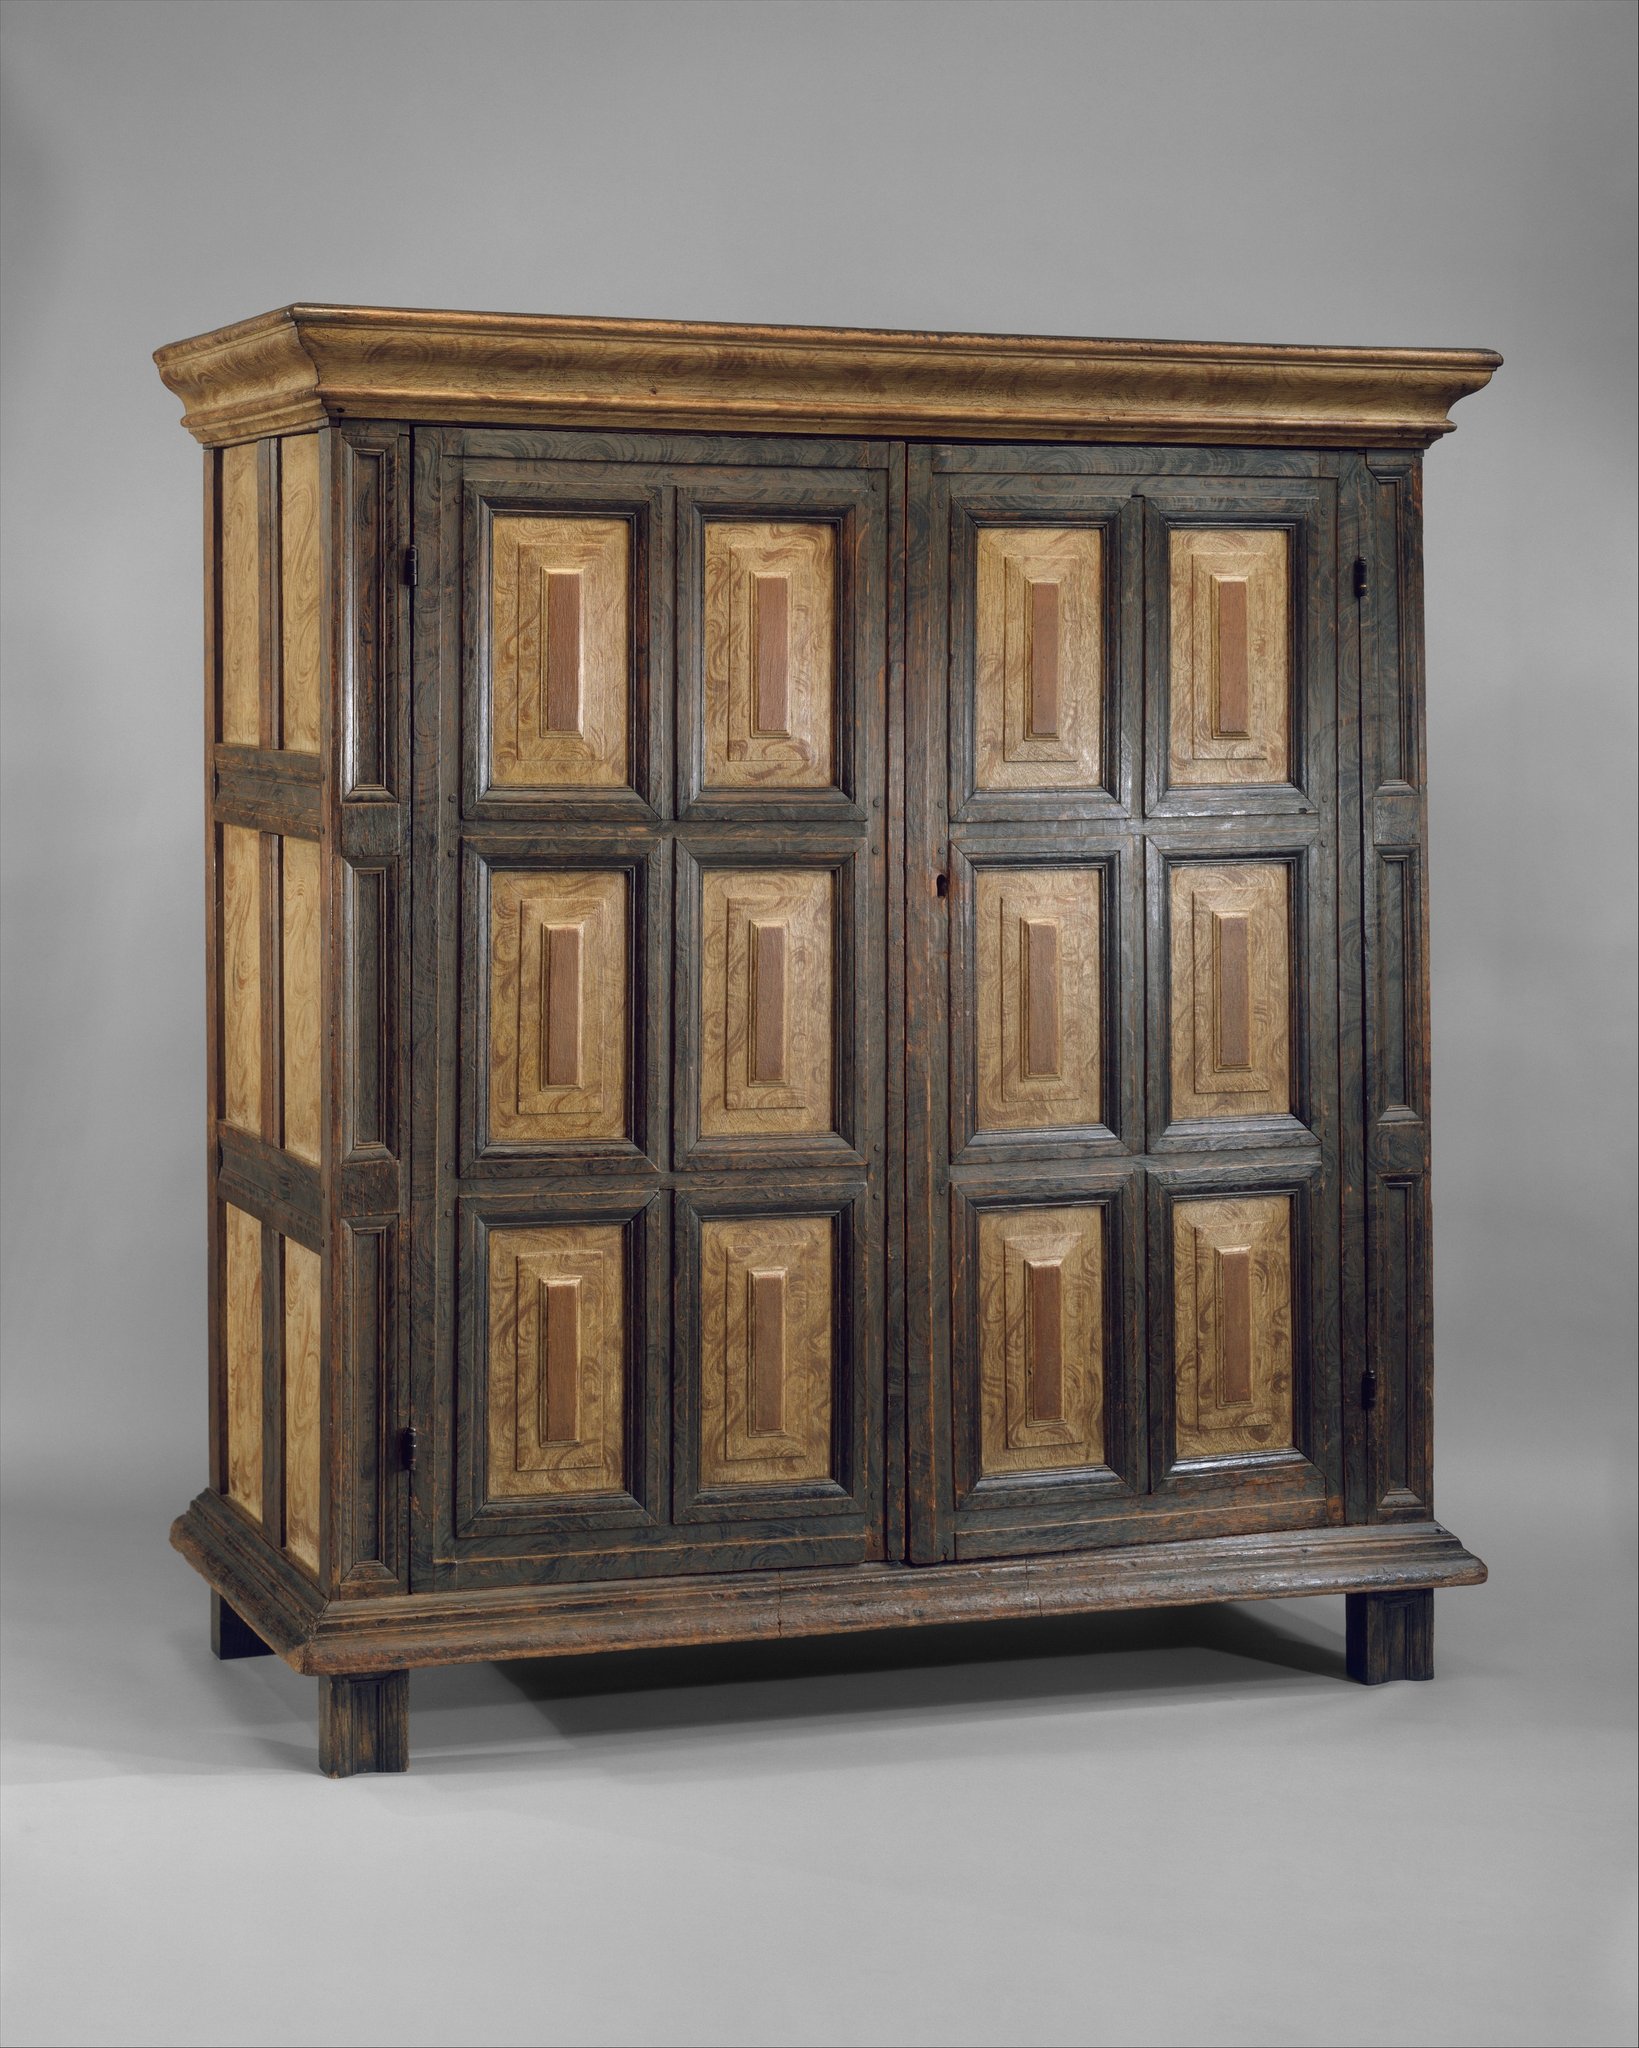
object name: kast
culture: american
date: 1650-1700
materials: wood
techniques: painting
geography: united states